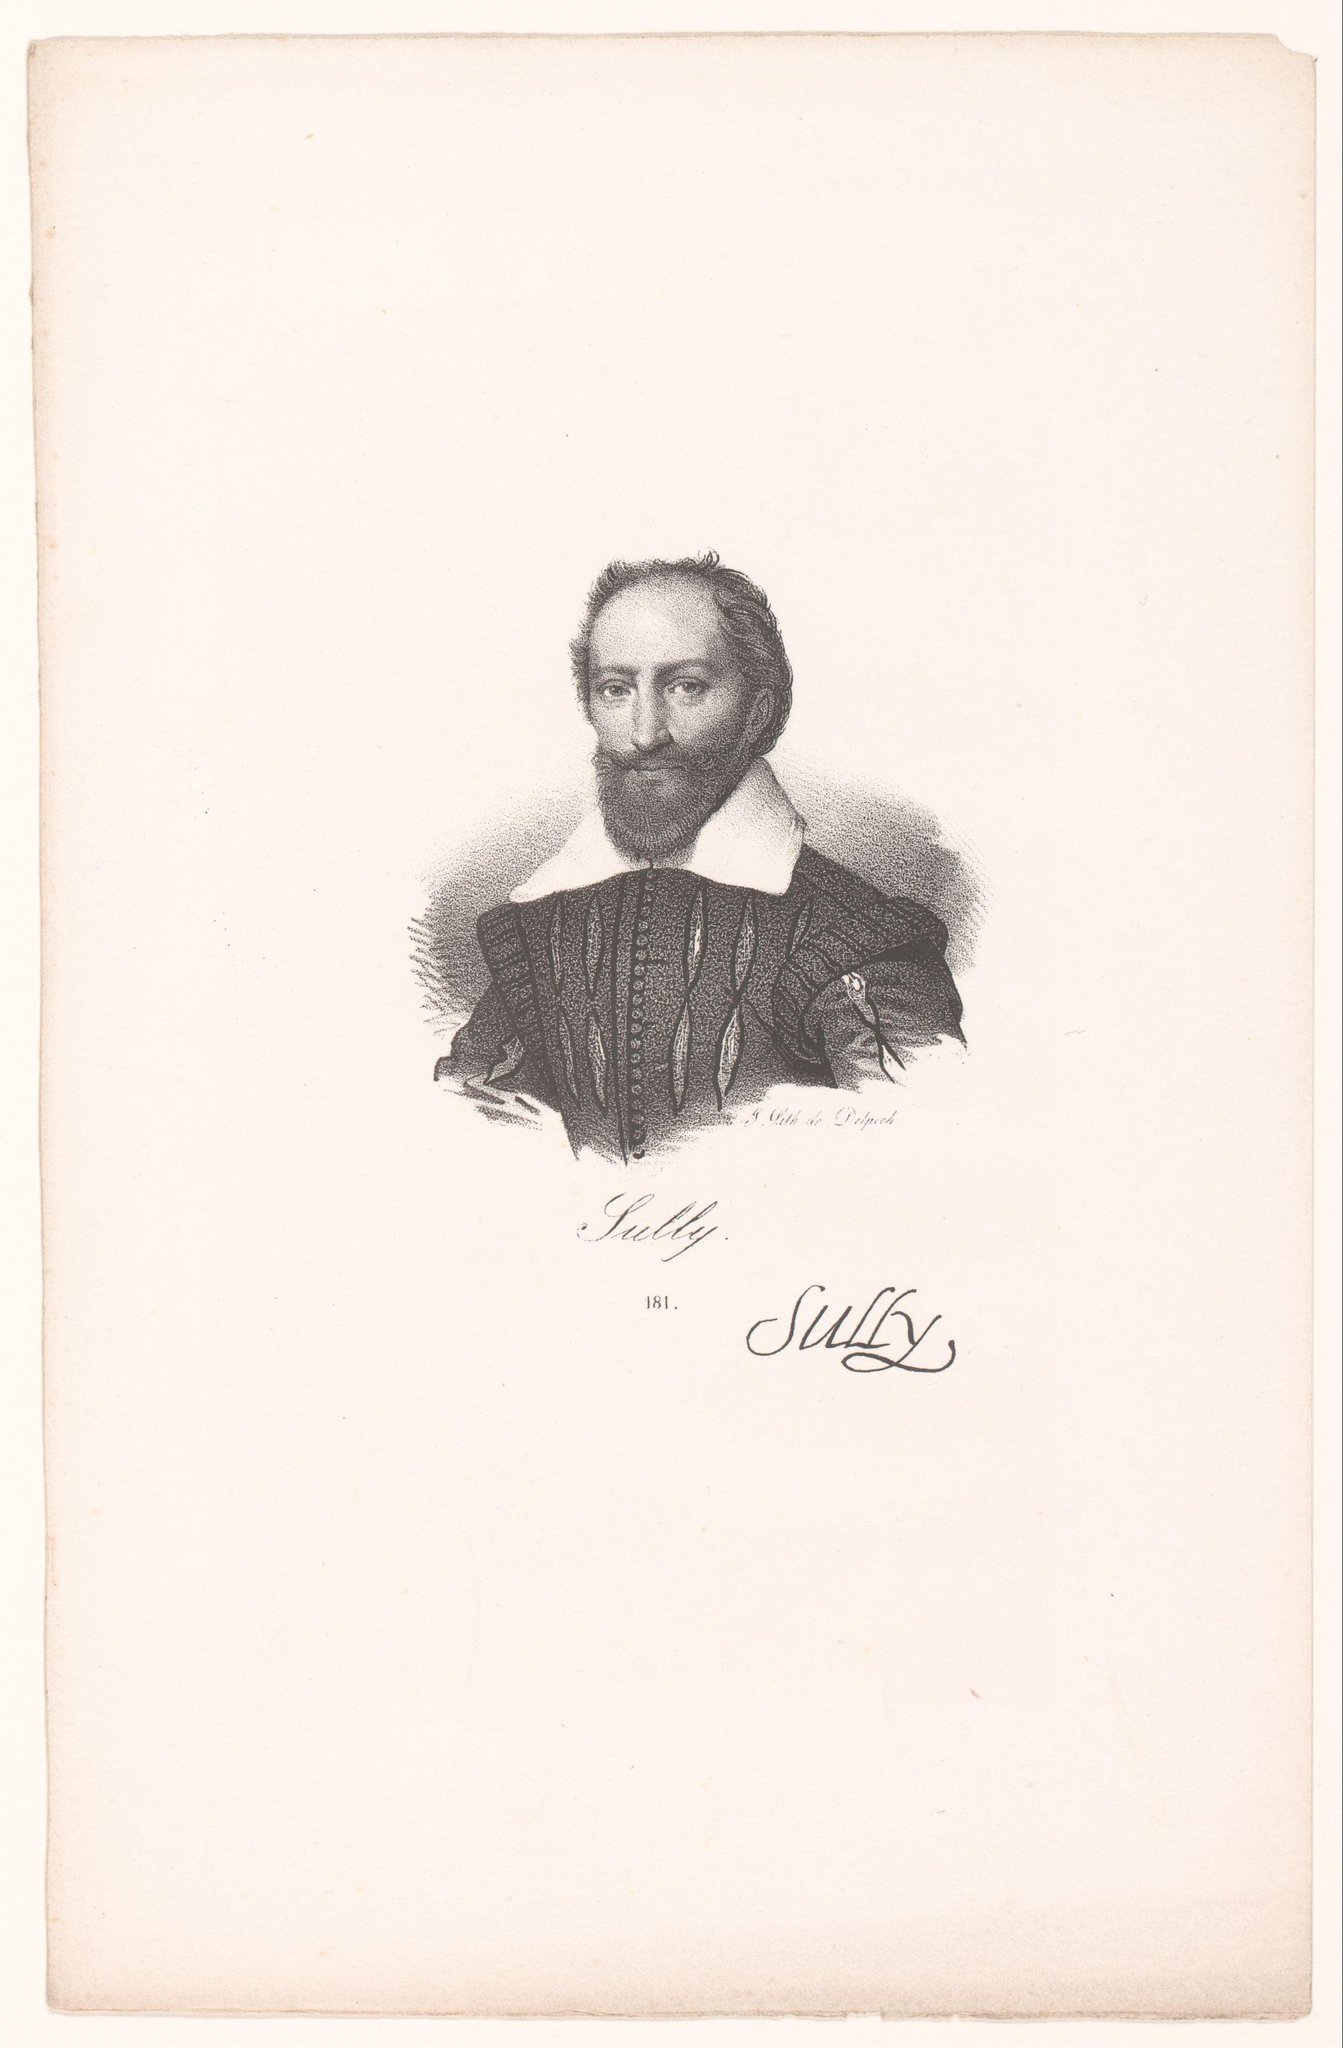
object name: print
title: Portret van Maximilien de Béthune, hertog van Sully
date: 1818-1842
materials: paper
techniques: lithograph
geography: paris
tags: maximilien de béthune (duke of sully), historical persons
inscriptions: collector's mark: Lugt 2228a